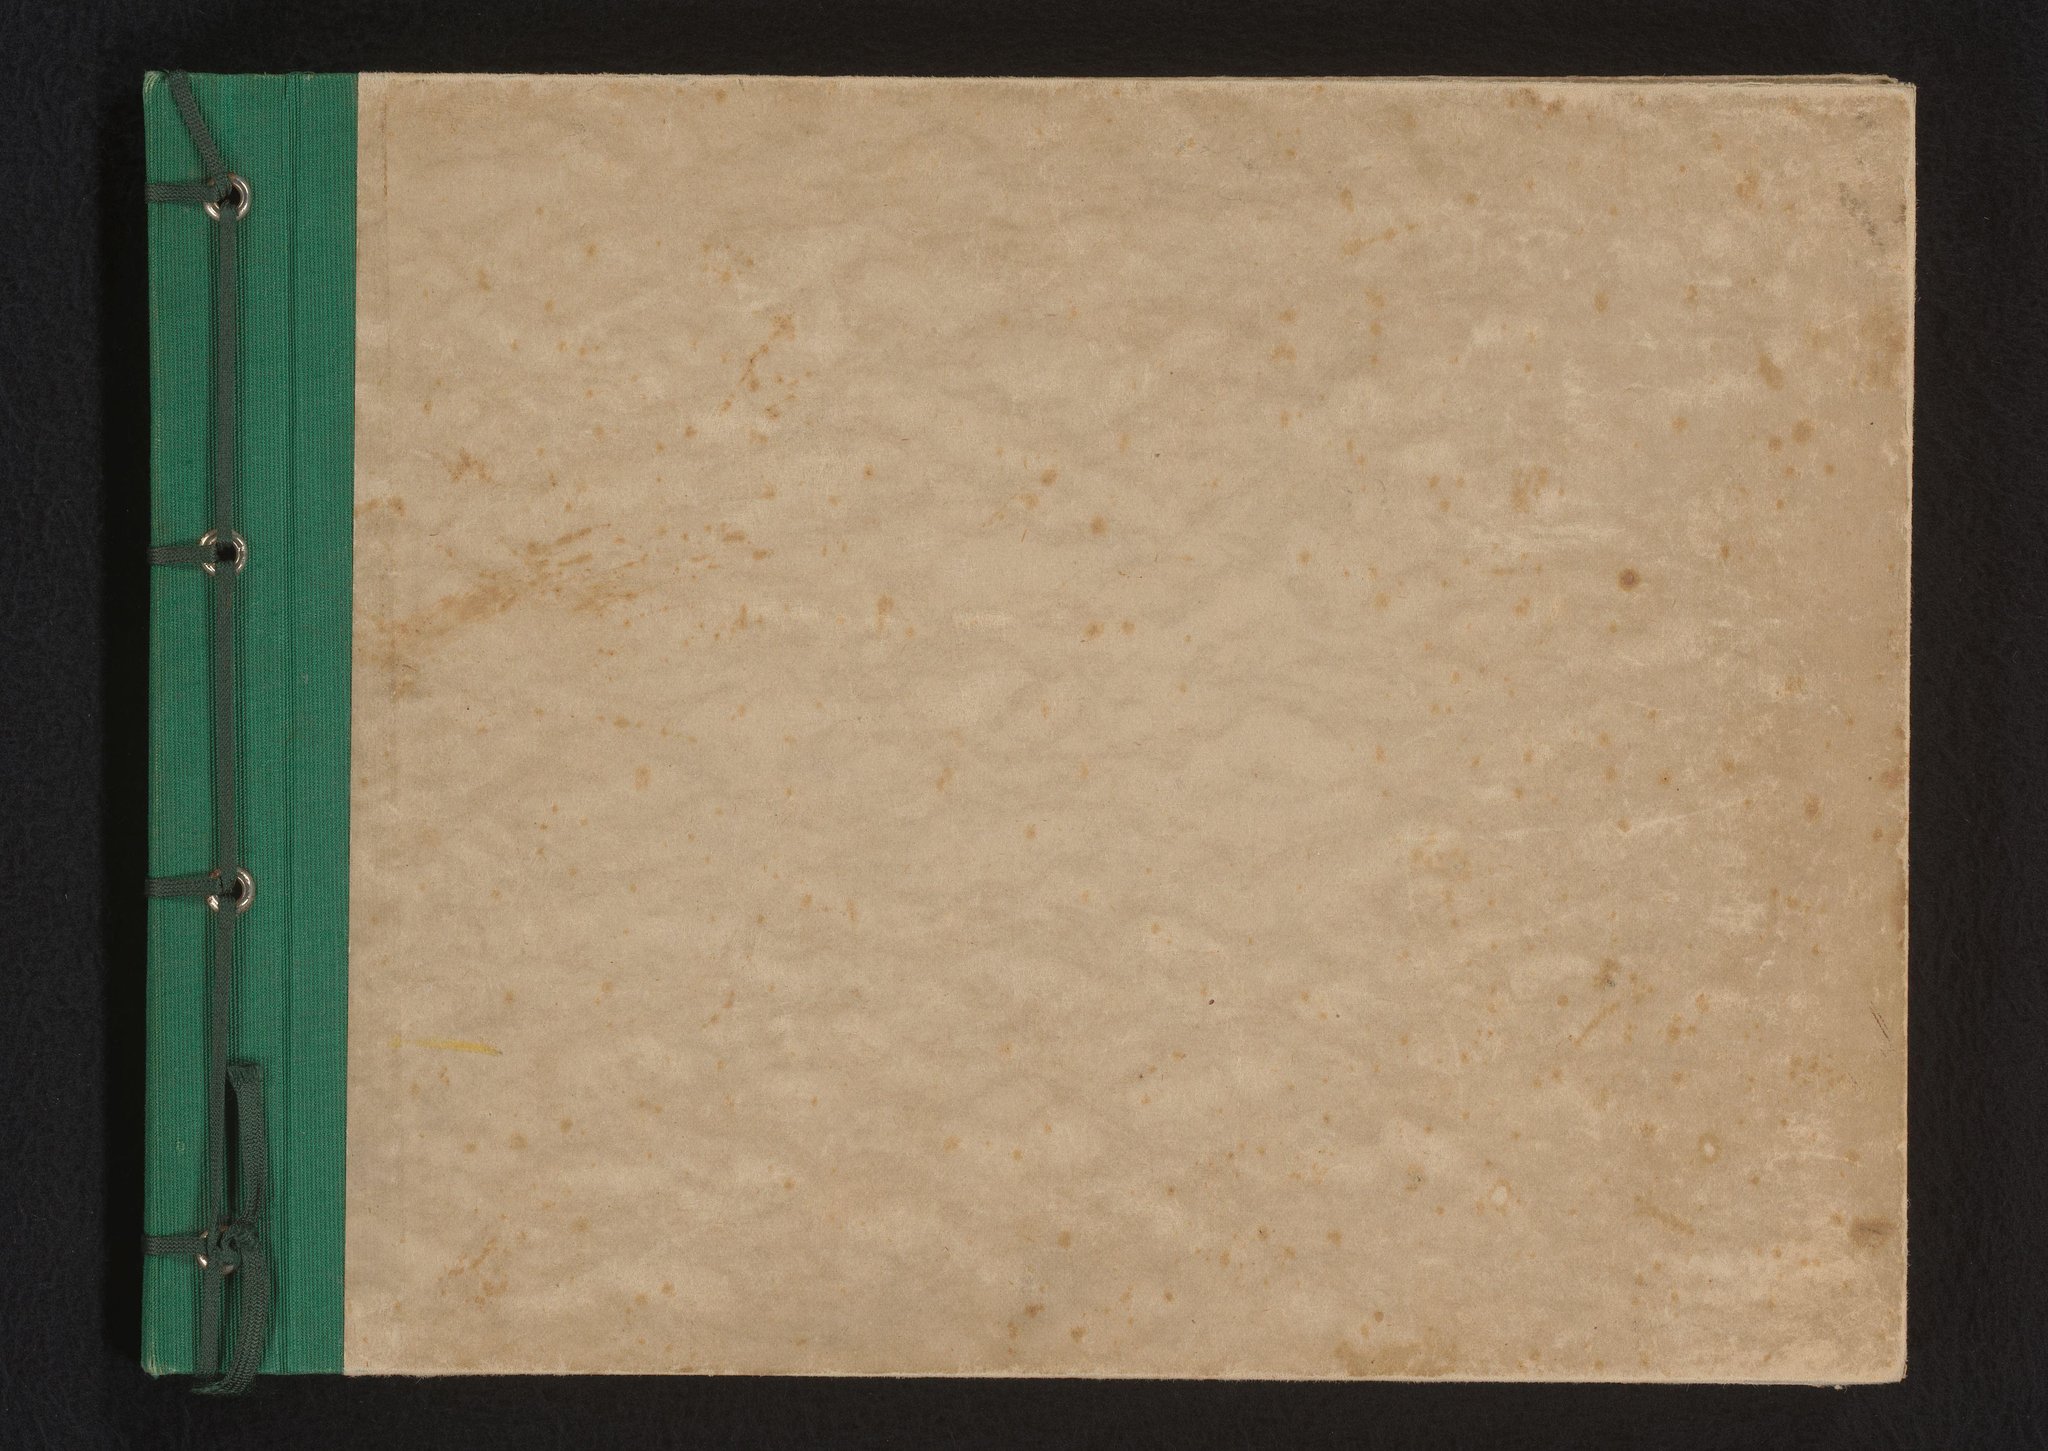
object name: photograph album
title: Hitlerjugend album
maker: Anonymous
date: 1935-1938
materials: cardboard, linen, paper, photographic support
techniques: photography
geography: germany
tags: germany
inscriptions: date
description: Fotoalbum met 91 foto's over een jongenskamp van de Hitlerjugend. Het album bevat 10 kartonnen bladen met een zwart koord bijeengehouden in een hard kartonnen kaft. Op de binnenzijde van de kaft staat: 'Fritz Lüft Heiermann im Landjahr-Lager 1938 (1935), Wolmersdorf in Schleswig-Holstein'. In een 'Landjahr-lager' kwamen jongens of meisjes bijeen die in een zelfde jaar geboren waren. Groot deel van de foto's is privé, klein deel lijkt in grote oplage gemaakt te zijn. Drie foto's betreffen een bezoek van Adolf Hitler aan een marineschip, op twee is hij zelf te zien.